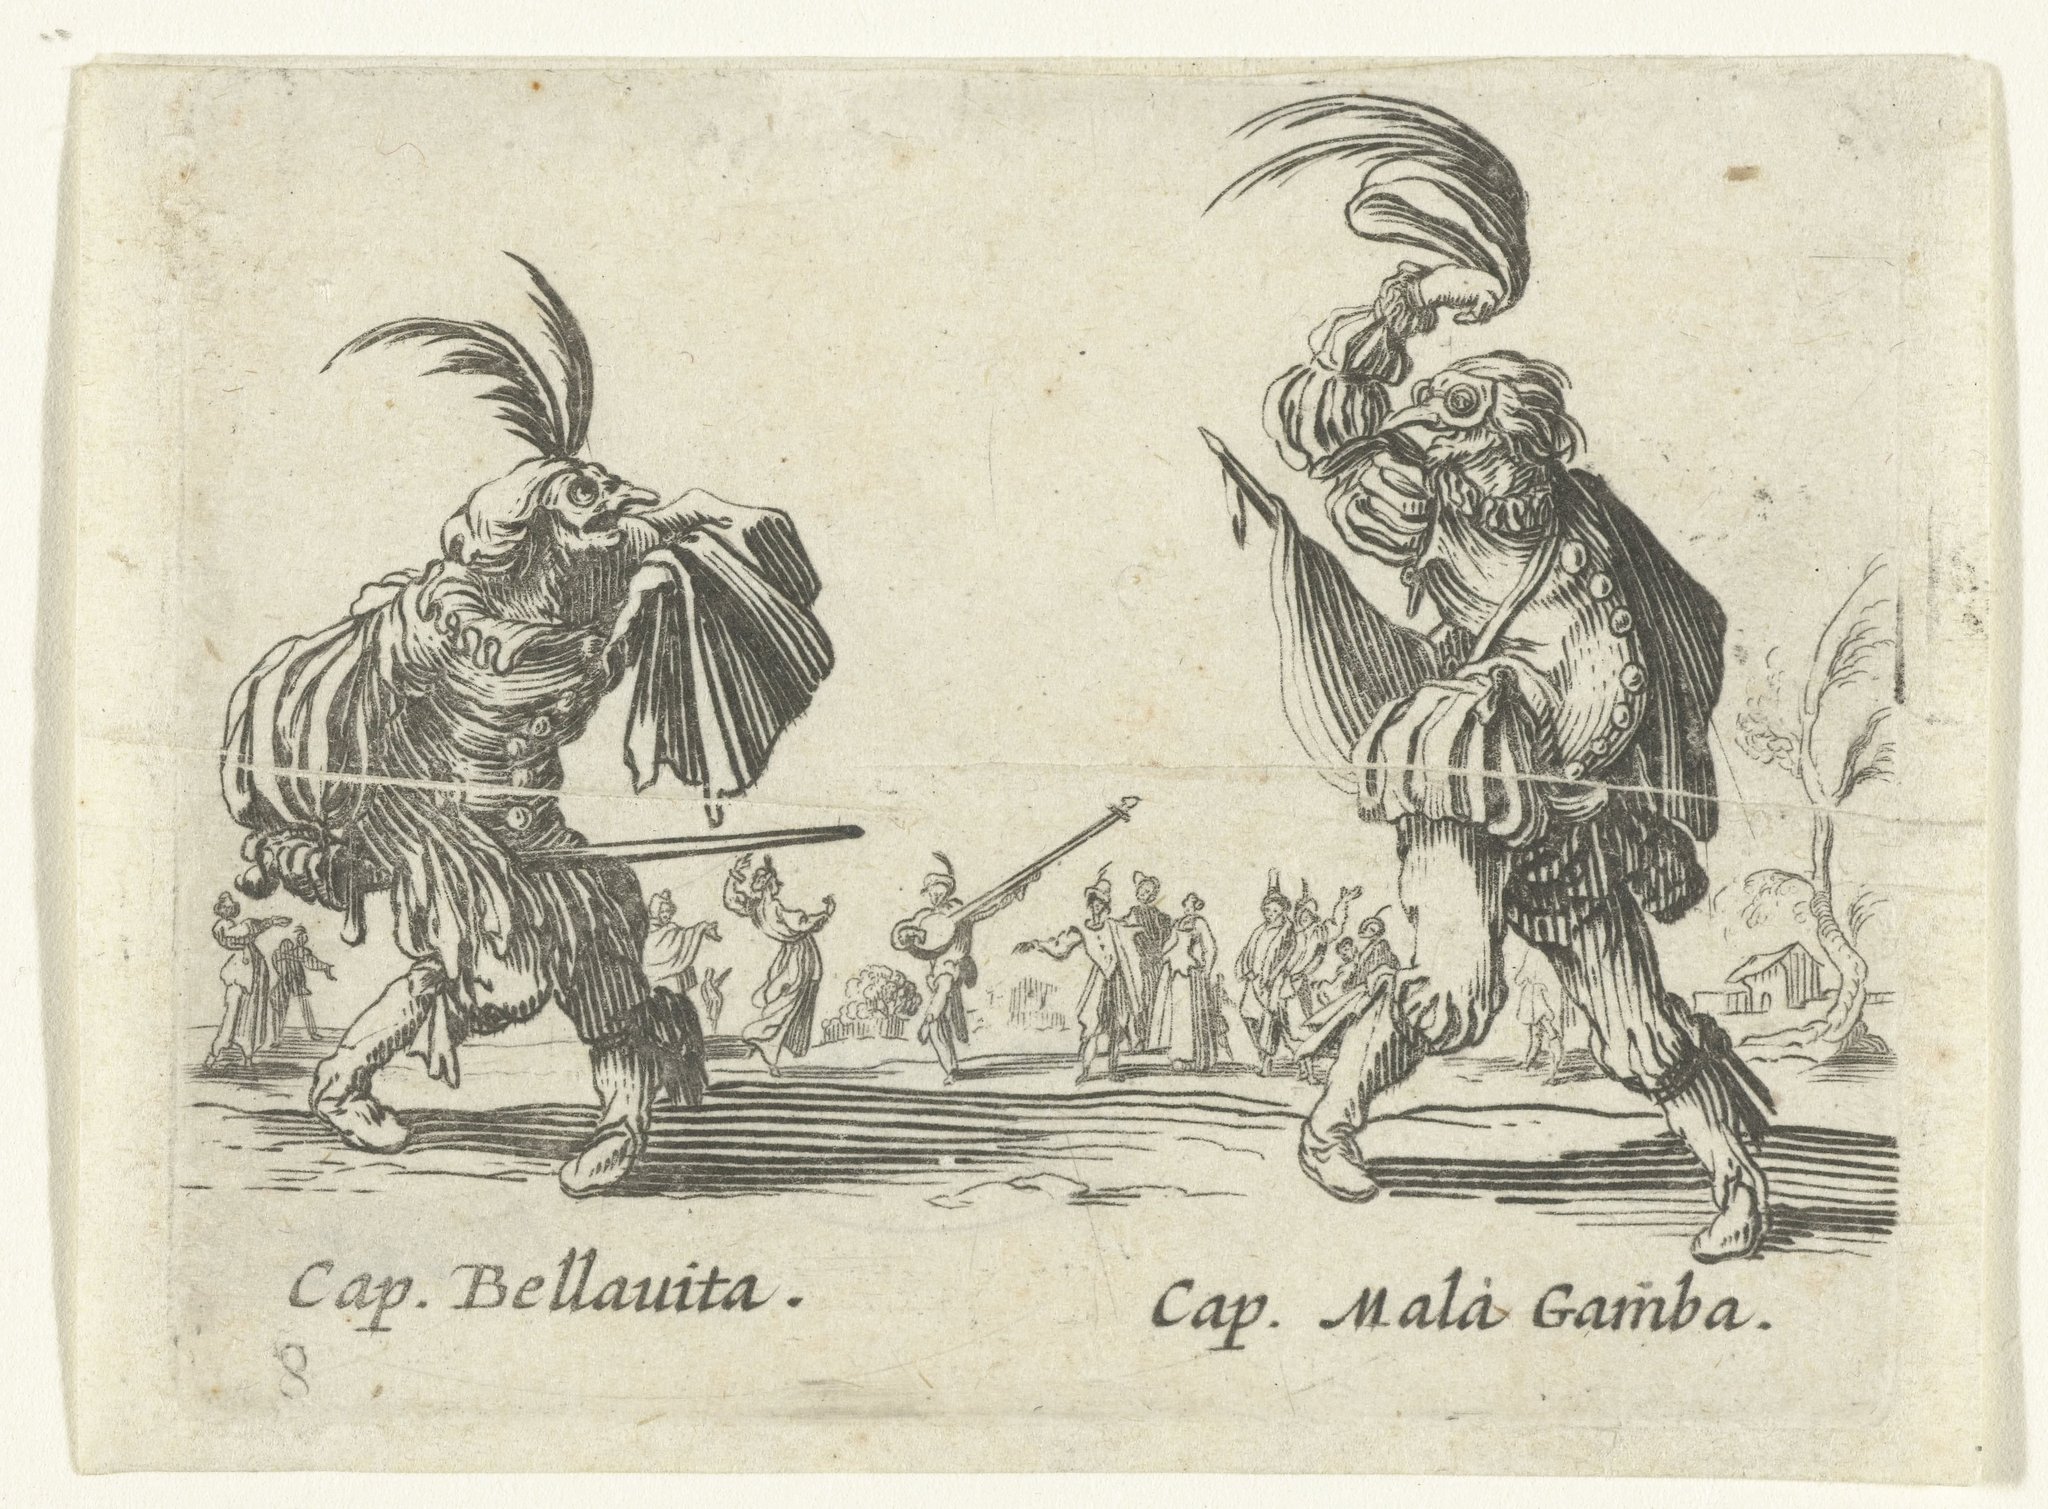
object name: print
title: Balli di Sfessania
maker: Anonymous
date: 1622-1670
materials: paper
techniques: etching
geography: low countries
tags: types in 'commedia dell'arte'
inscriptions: collector's mark: Lugt 2228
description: Twee artiesten met gevederde hoofddeksels op staan naast elkaar. De linker figuur maakt met zijn zwaard een obsceen gebaar naar de rechter. Onder de figuren staan hun namen genoteerd. Deze prent is onderdeel van een serie van 23 prenten (24 incl. titelprent) met telkens op de voorgrond twee straatartiesten verkleed als figuren uit de Italiaanse commedia dell'arte, en op de achtergrond toeschouwers die in de buitenlucht een (dans)voorstelling van straatartiesten gadeslaan.